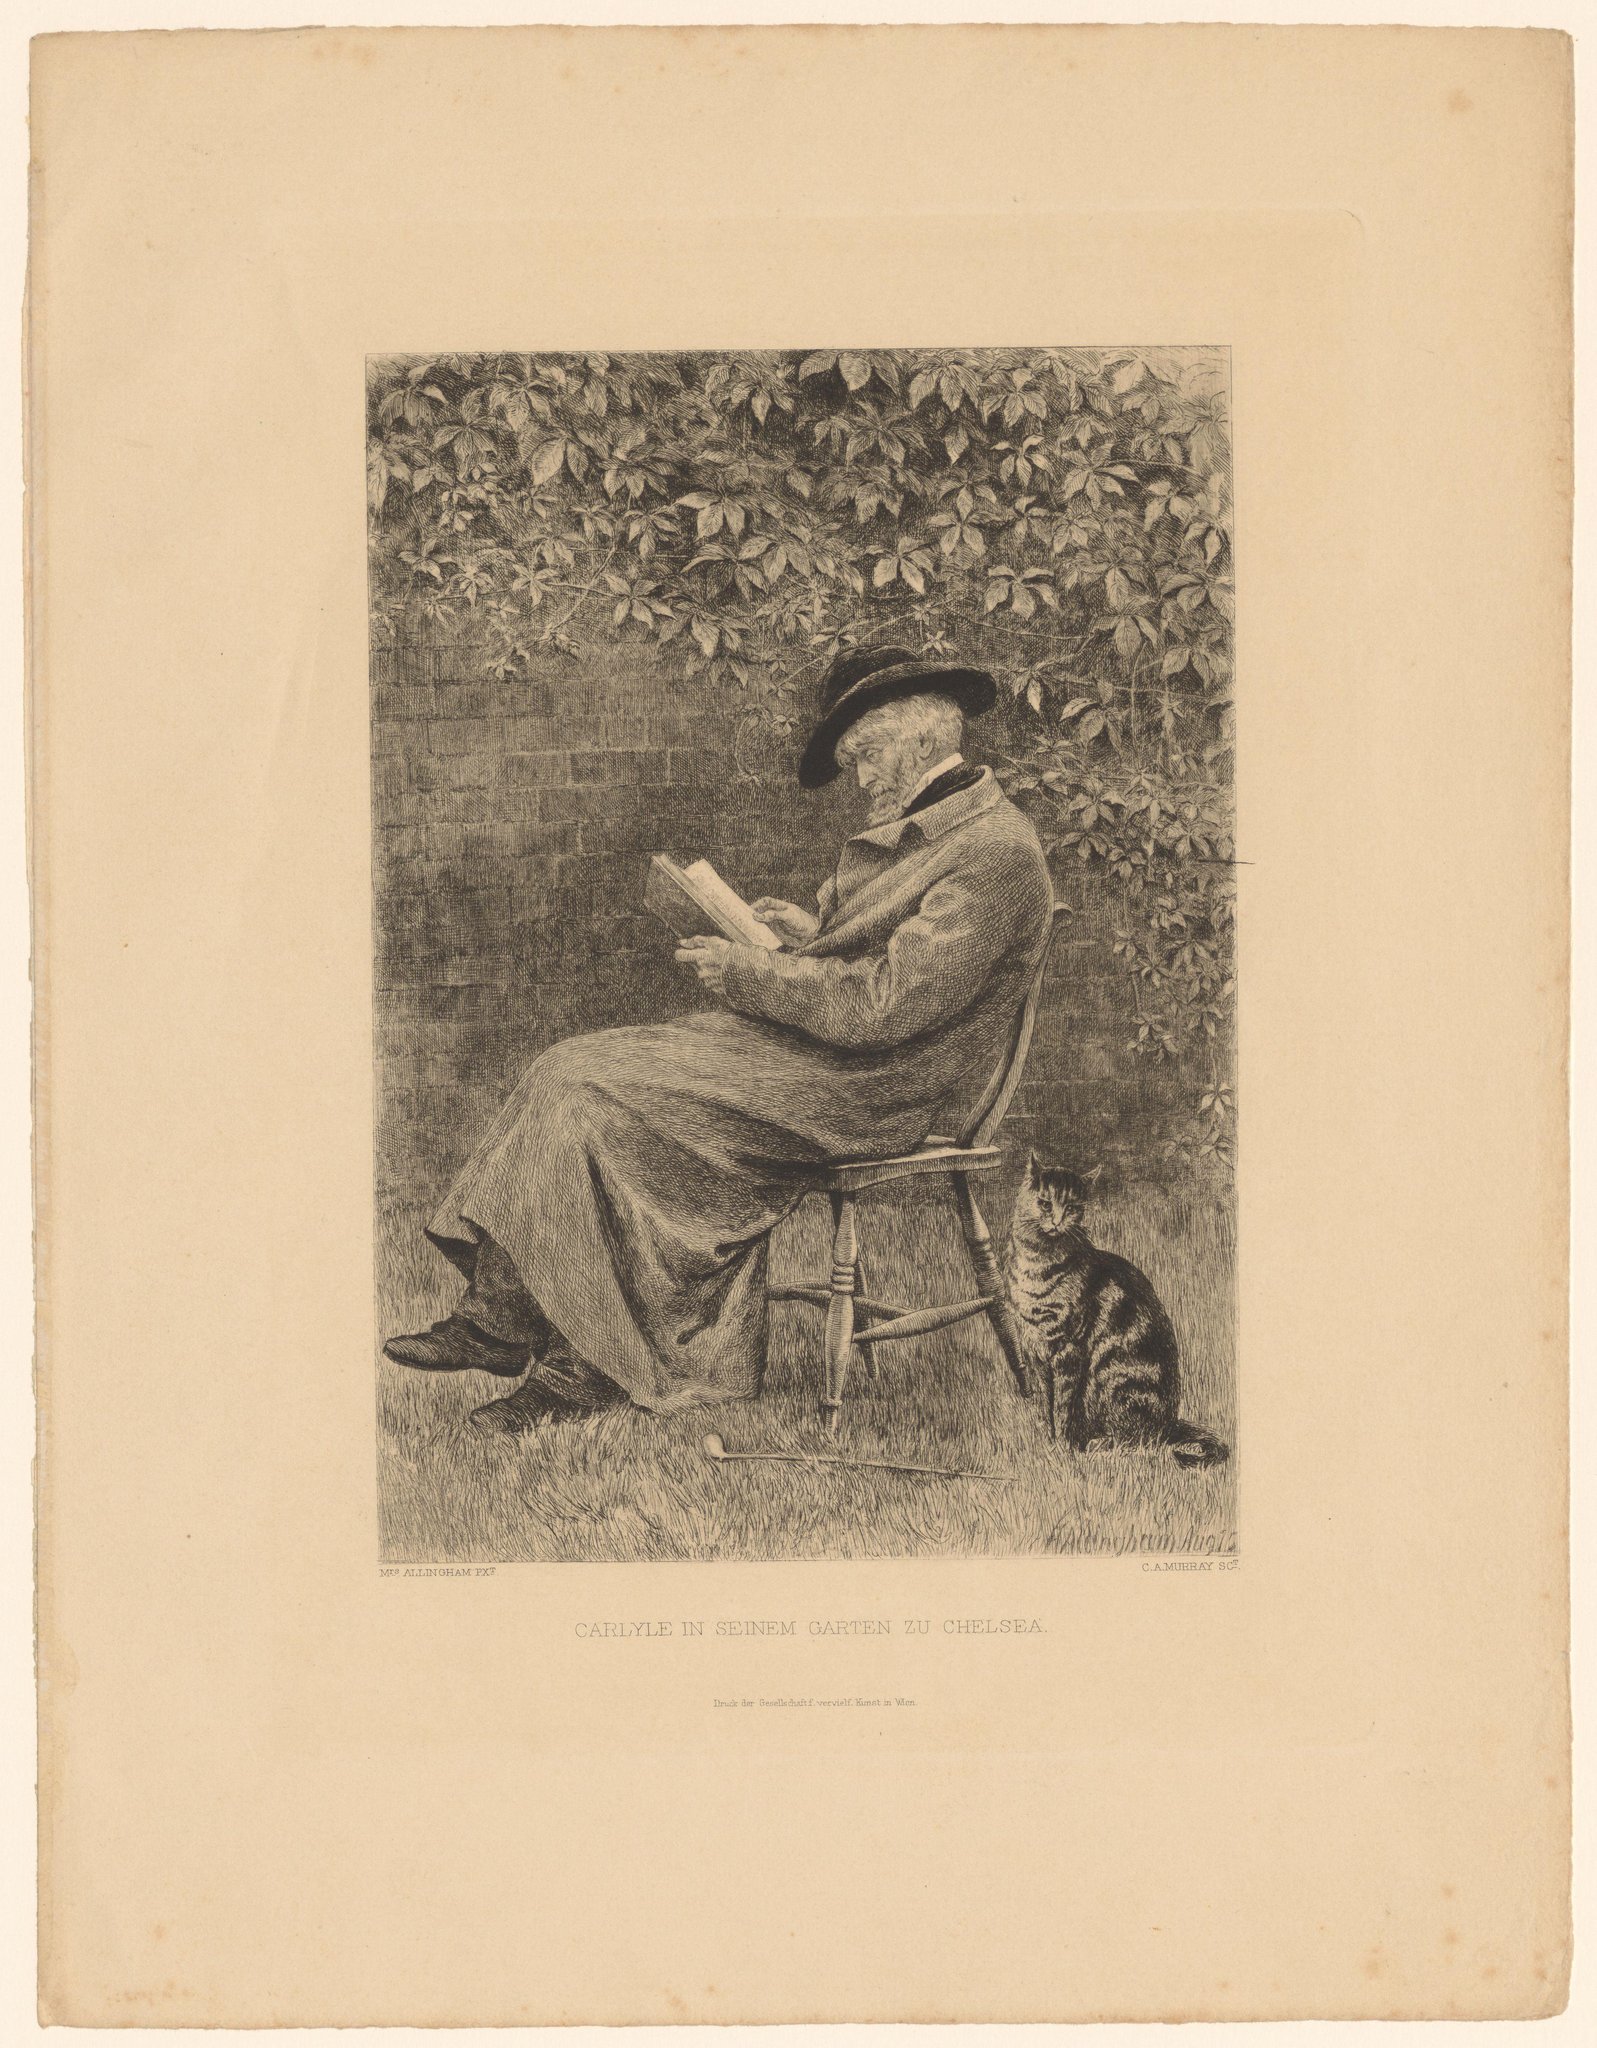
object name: print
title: Thomas Carlyle lezend in zijn tuin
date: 1882-1923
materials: paper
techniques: drypoint, etching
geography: england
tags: reading, cat, scholar, philosopher (+ portrait of scholar, scientist)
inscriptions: collector's mark: Lugt 2228